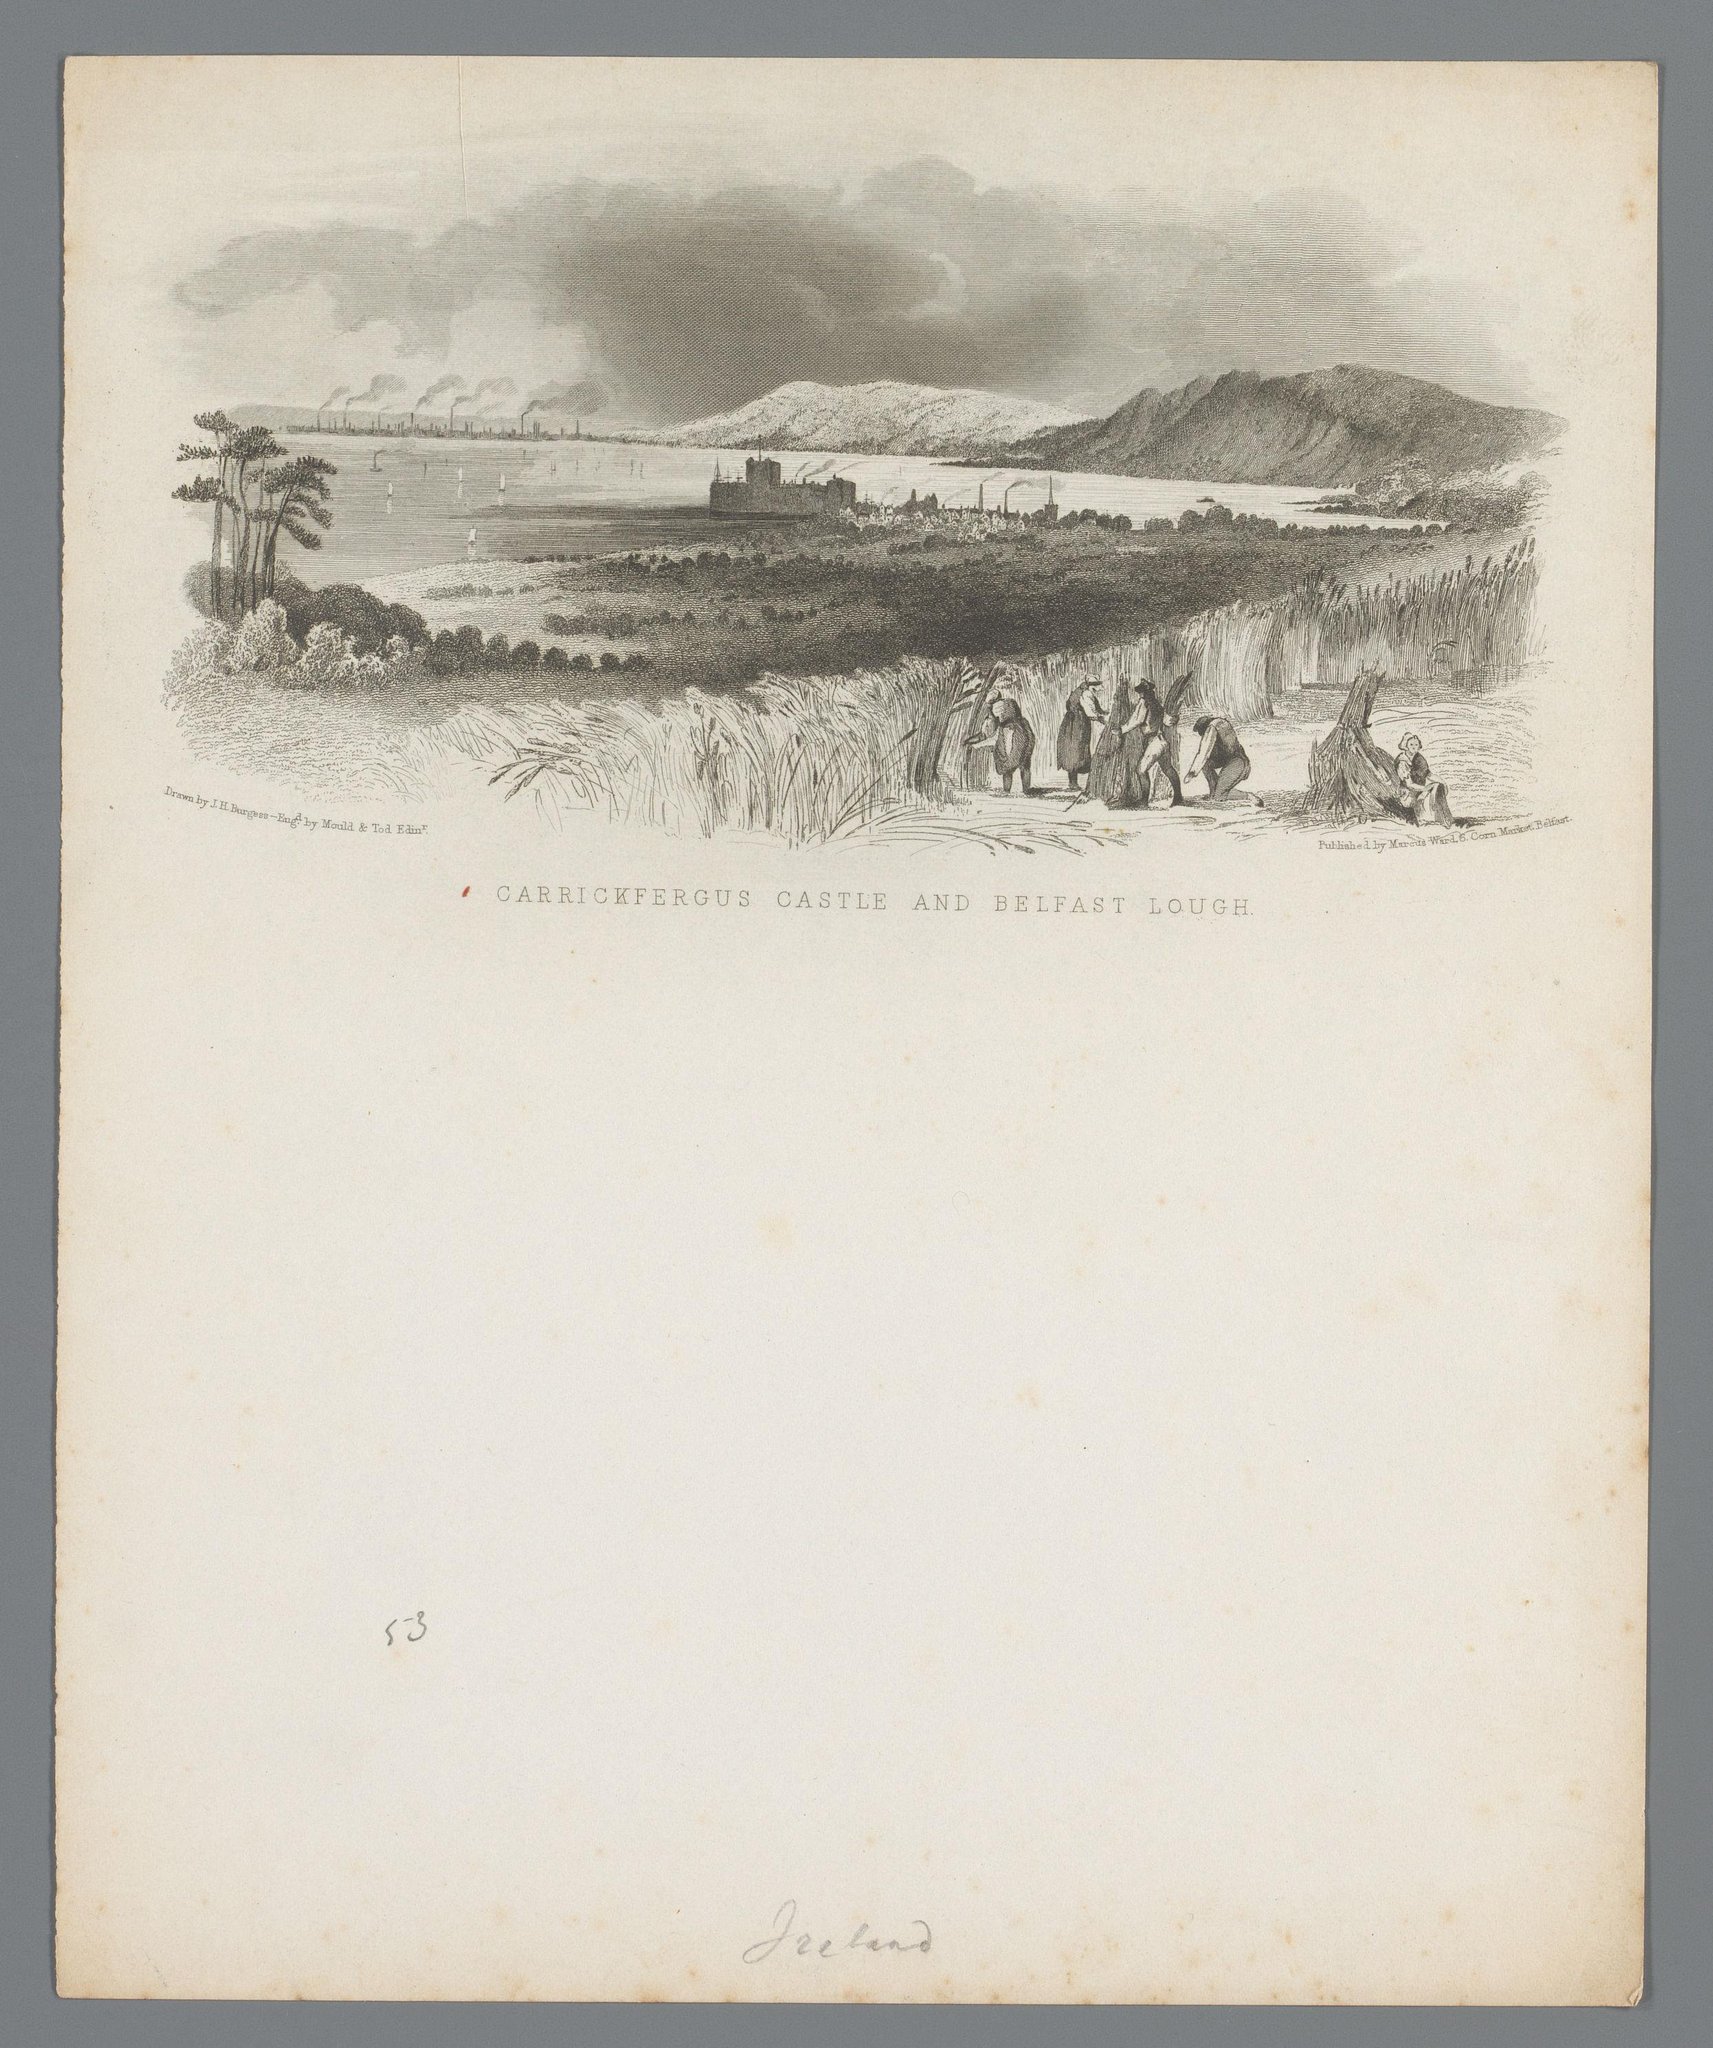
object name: print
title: Briefpapier met voorstelling van Carrickfergus Castle en Belfast Lough in Ierland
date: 1830-1850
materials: paper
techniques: engraving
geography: edinburgh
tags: coast